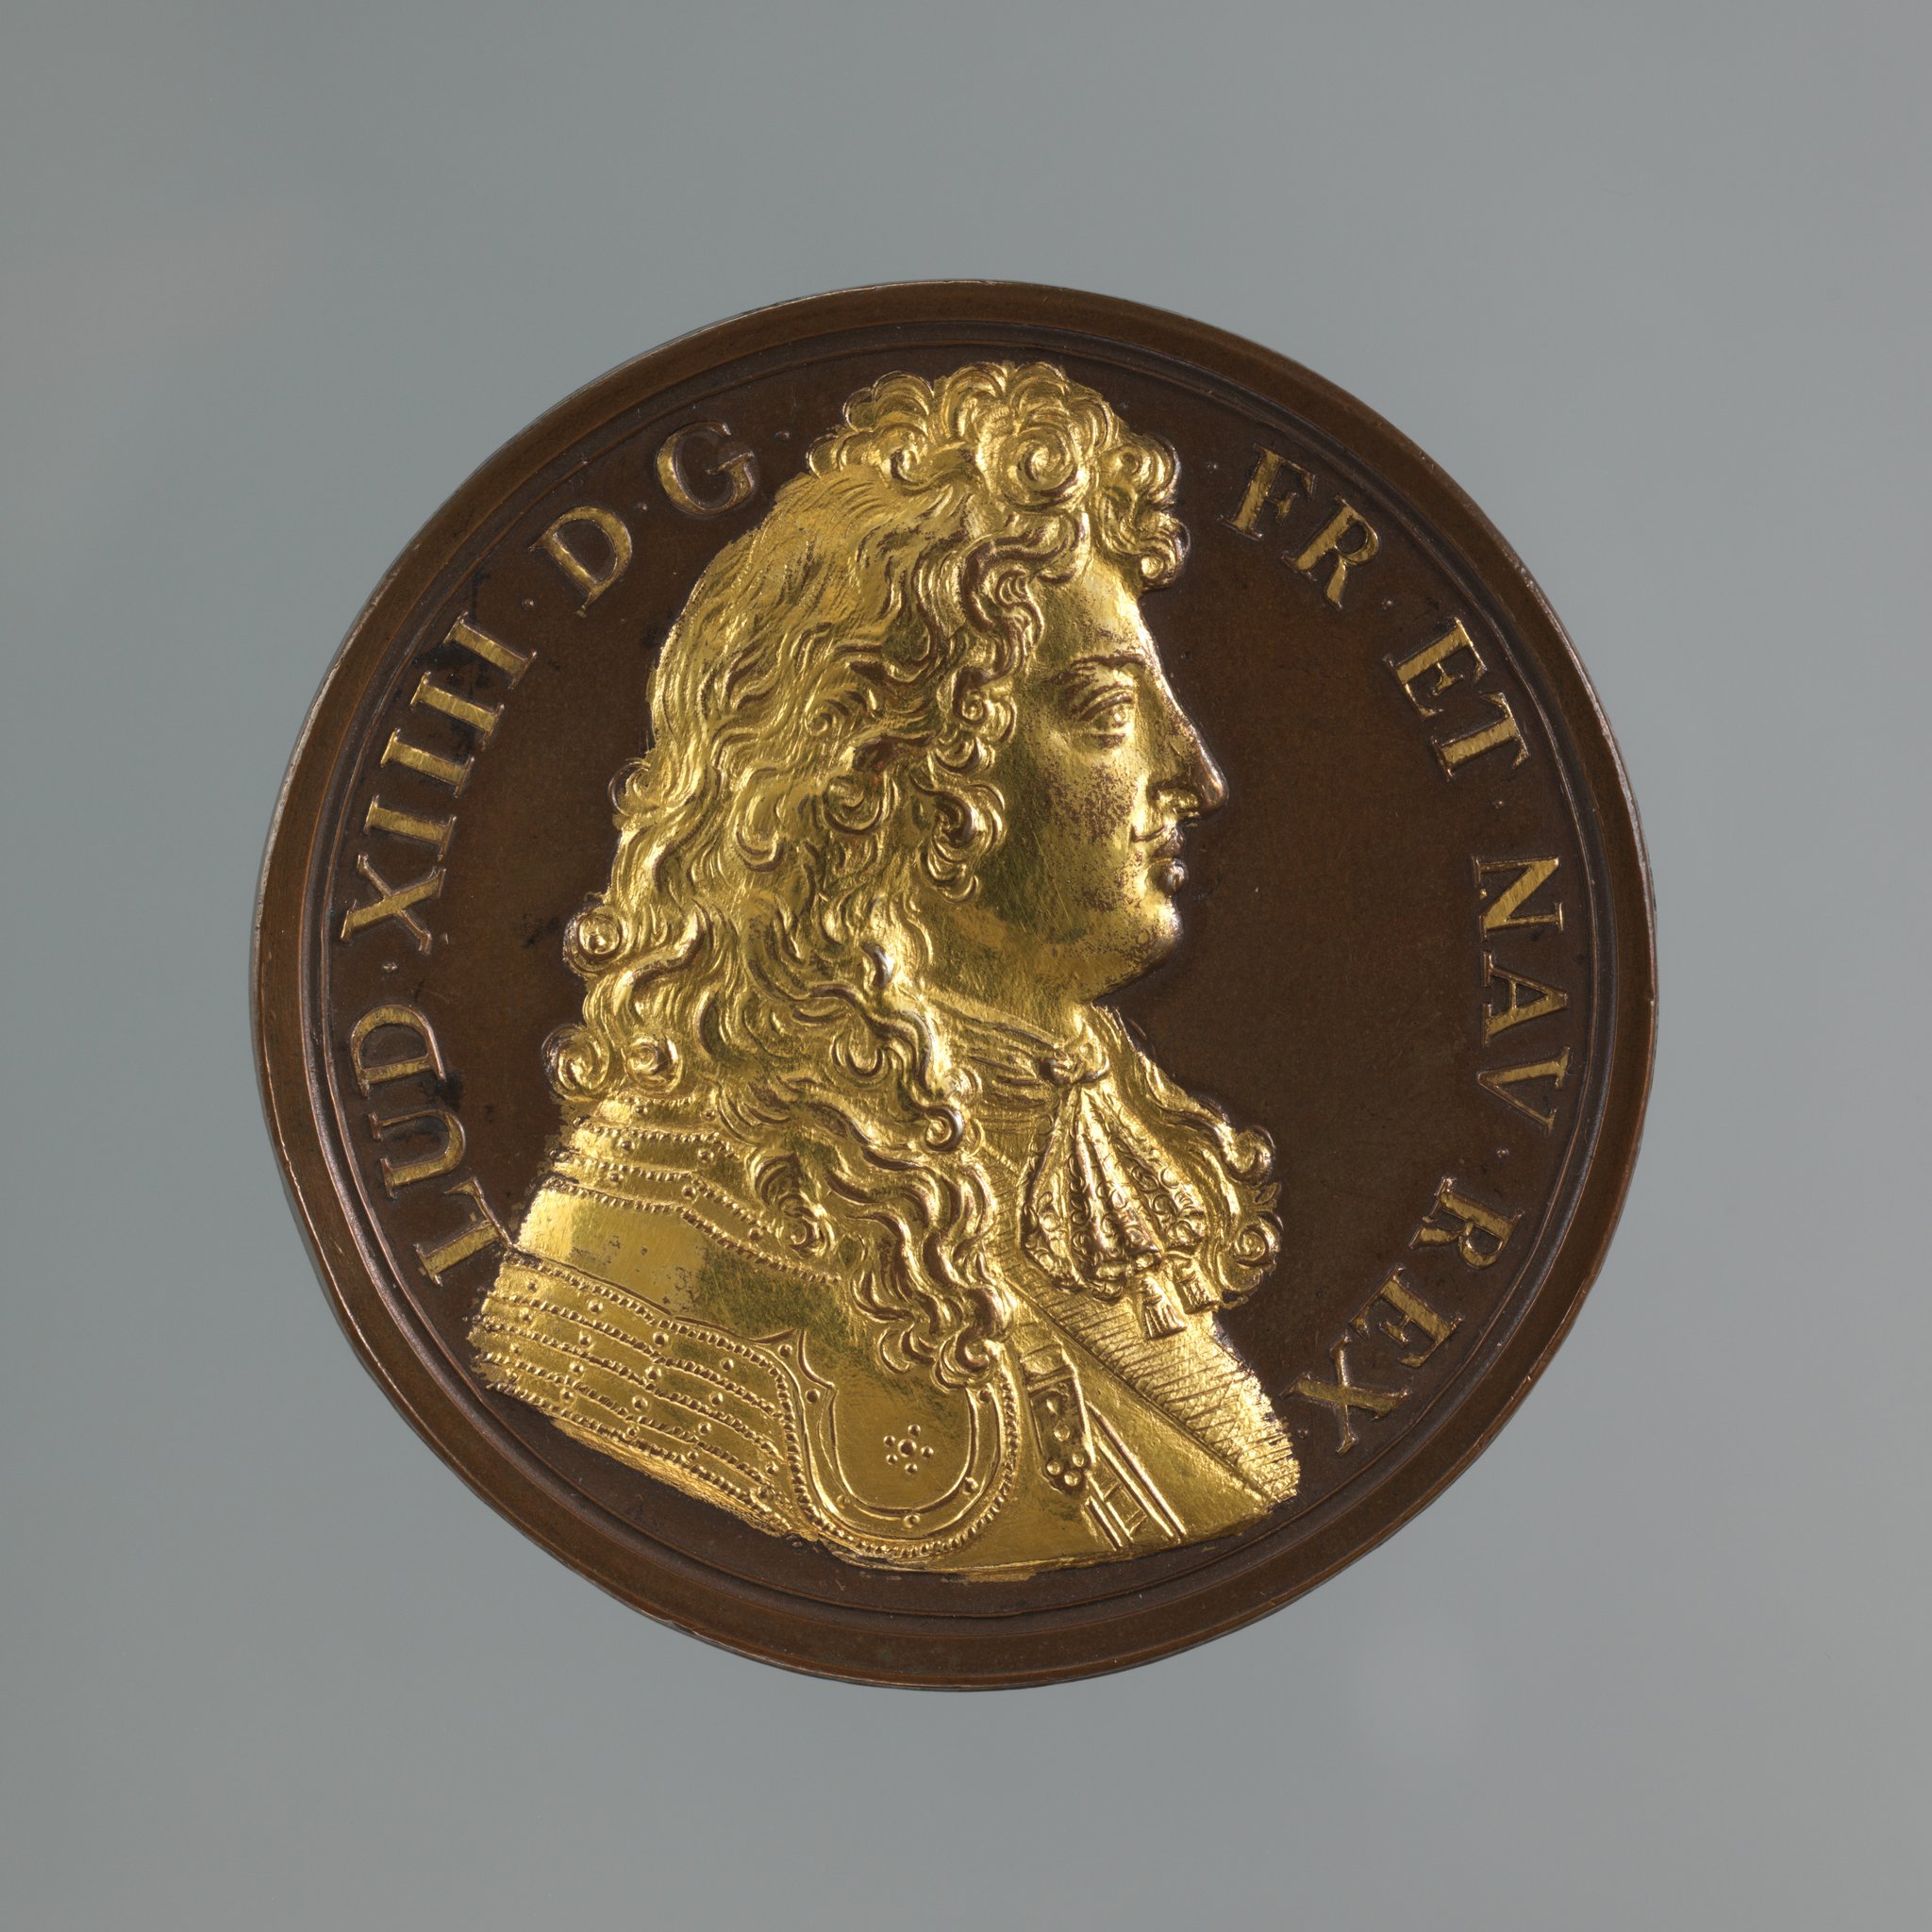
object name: medal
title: Louis XIV: The Battle of Saint Gotthard, 1664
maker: pierre aury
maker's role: artist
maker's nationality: french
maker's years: 1622-1699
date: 1701-1733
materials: bronze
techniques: gilding